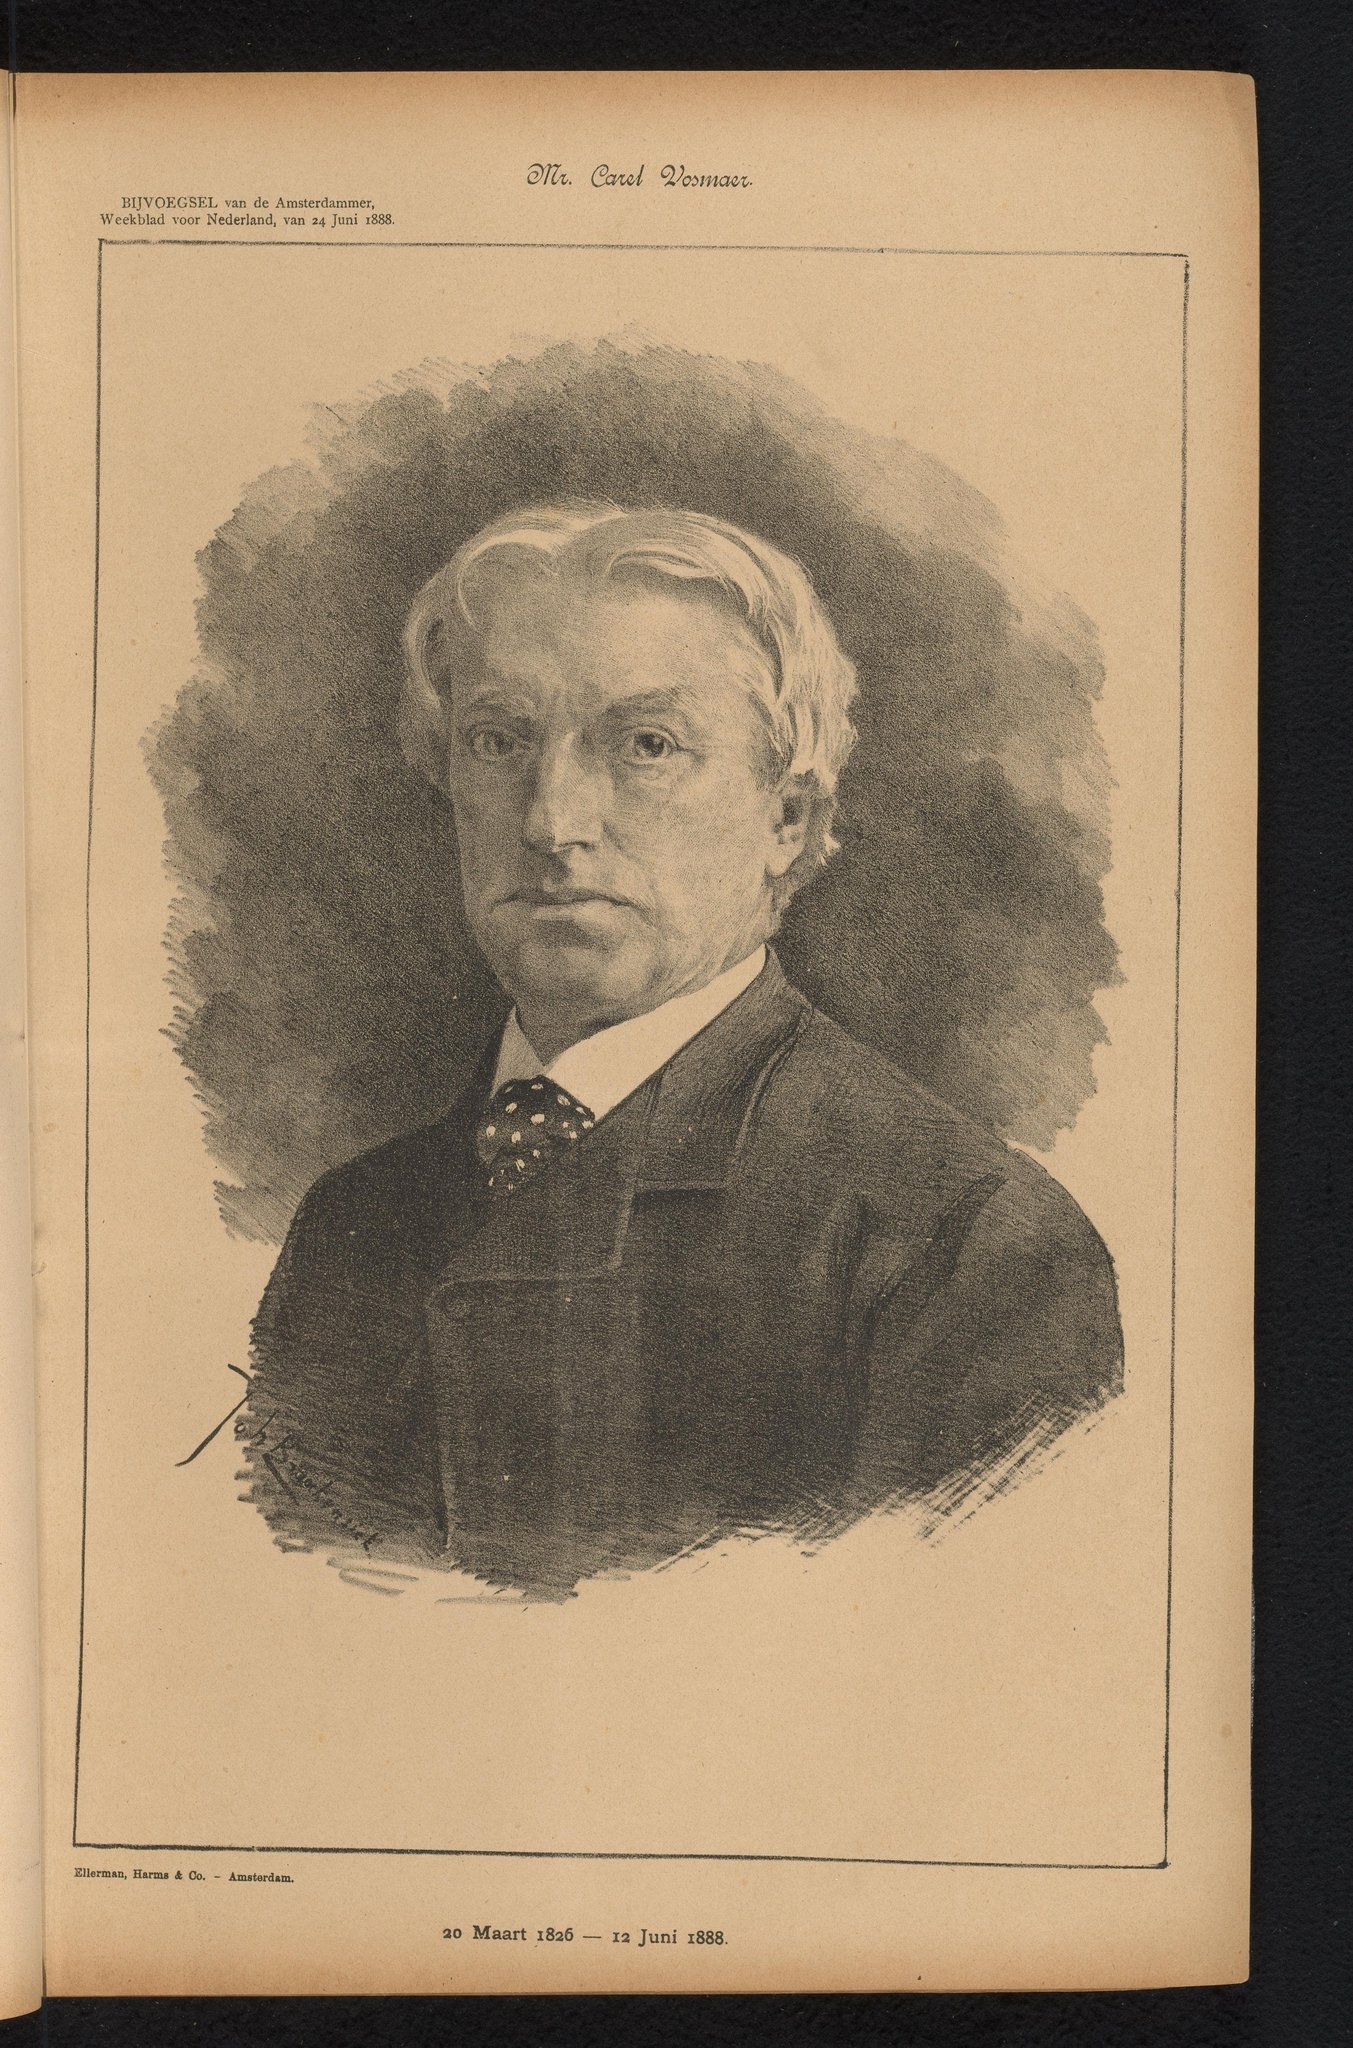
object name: print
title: Mr. Carel Vosmaer / 20 Maart 1826 - 12 Juni 1888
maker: johan braakensiek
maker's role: draughtsman, print maker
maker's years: 1858-1940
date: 1888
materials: paper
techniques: lithograph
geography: amsterdam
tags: the hague, print maker, draughtsman, carel vosmaer, historical persons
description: Gepubliceerd als bijvoegsel bij 'De Amsterdammer', 24 juni 1888.